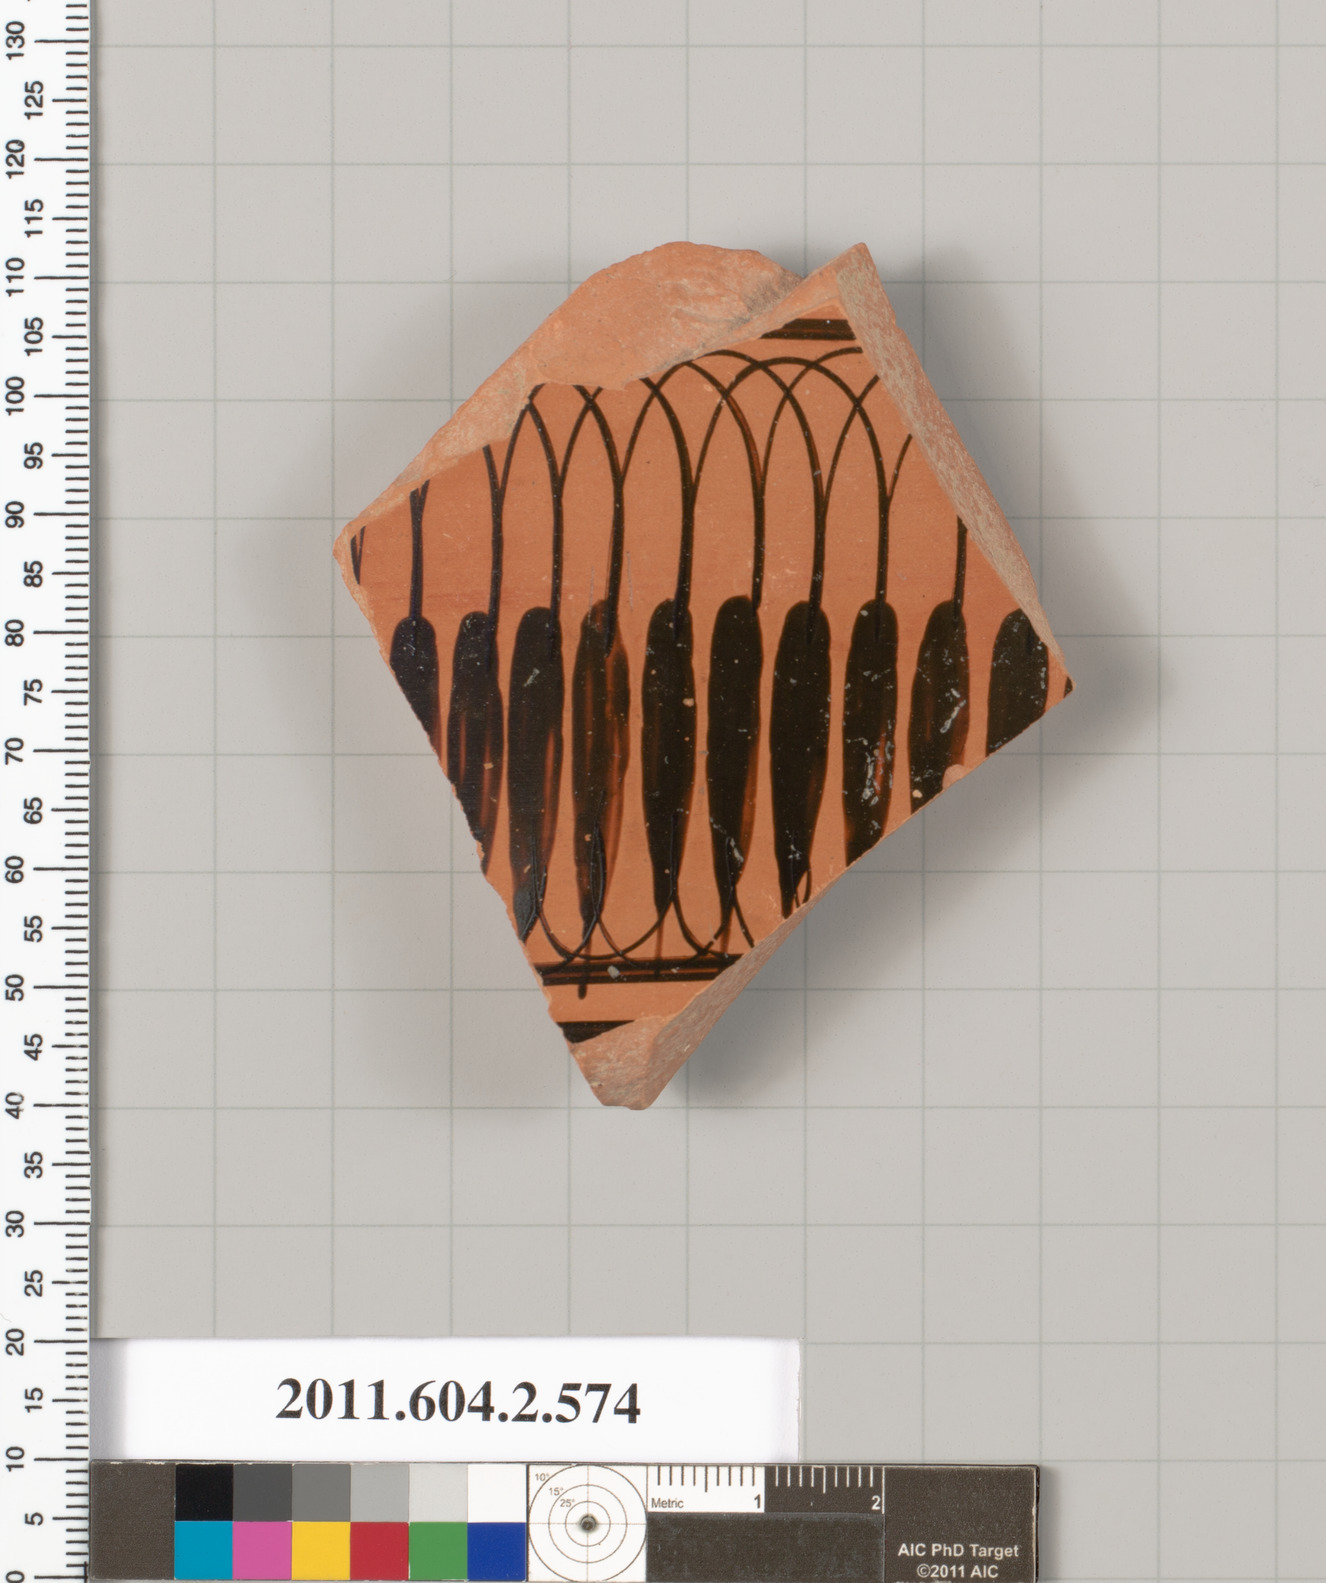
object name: column krater fragment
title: Terracotta fragment of a column-krater (bowl for mixing wine and water)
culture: greek, attic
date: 470-450 BCE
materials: terracotta